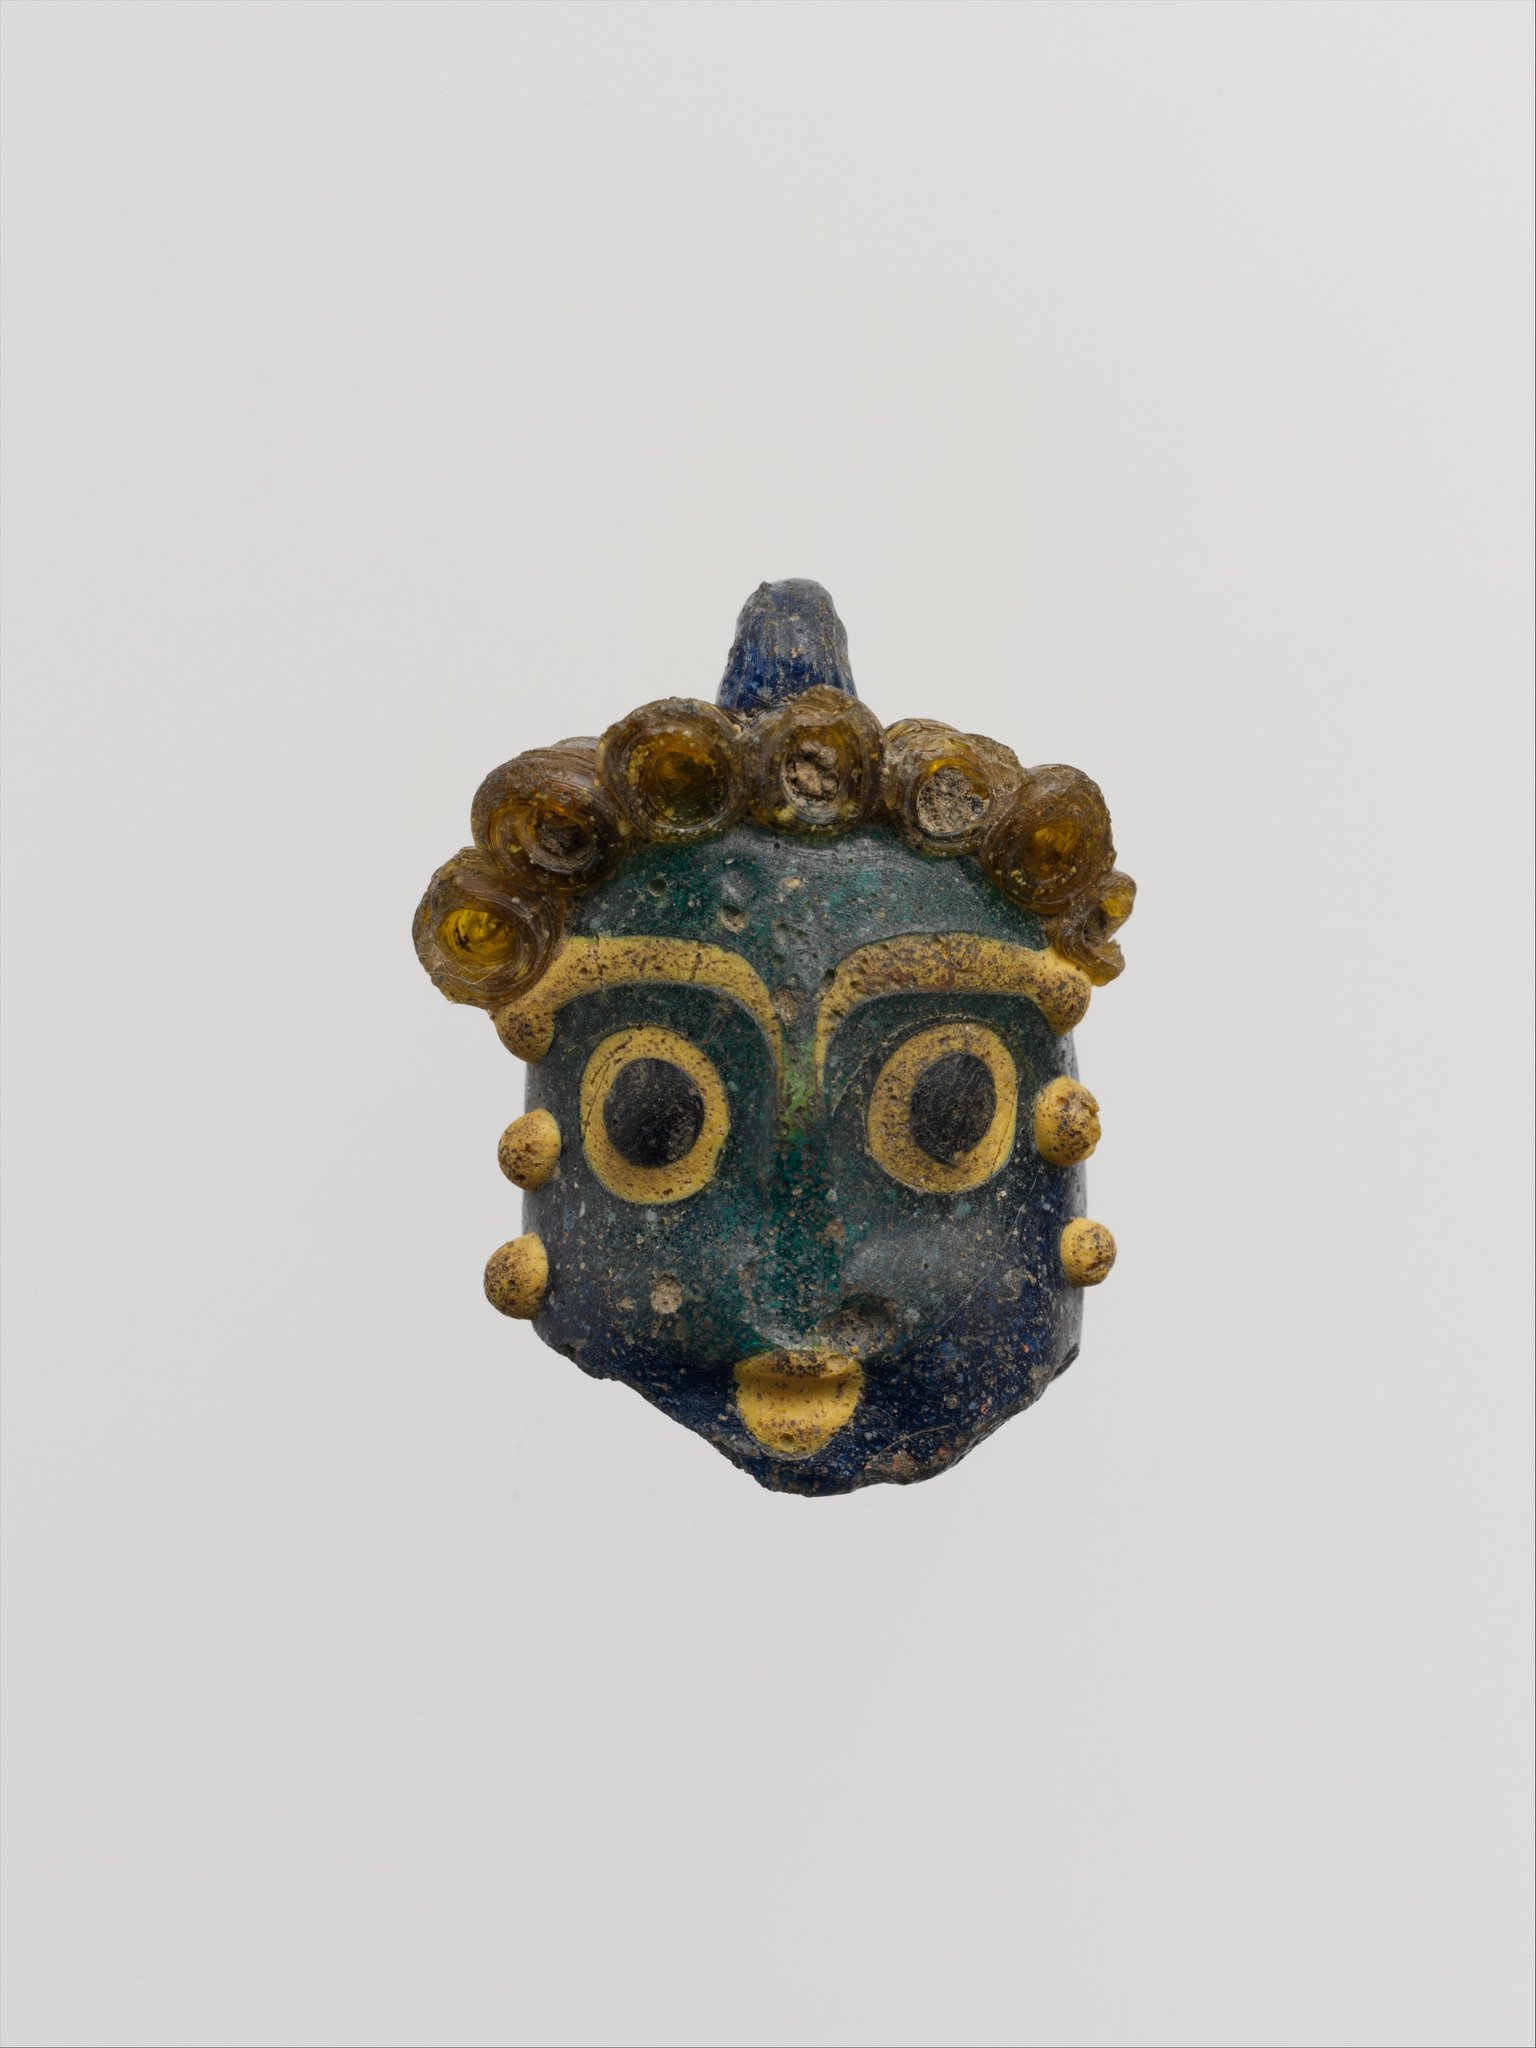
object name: head pendant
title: Glass head pendant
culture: carthaginian or phoenician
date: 500-401 BCE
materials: glass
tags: heads